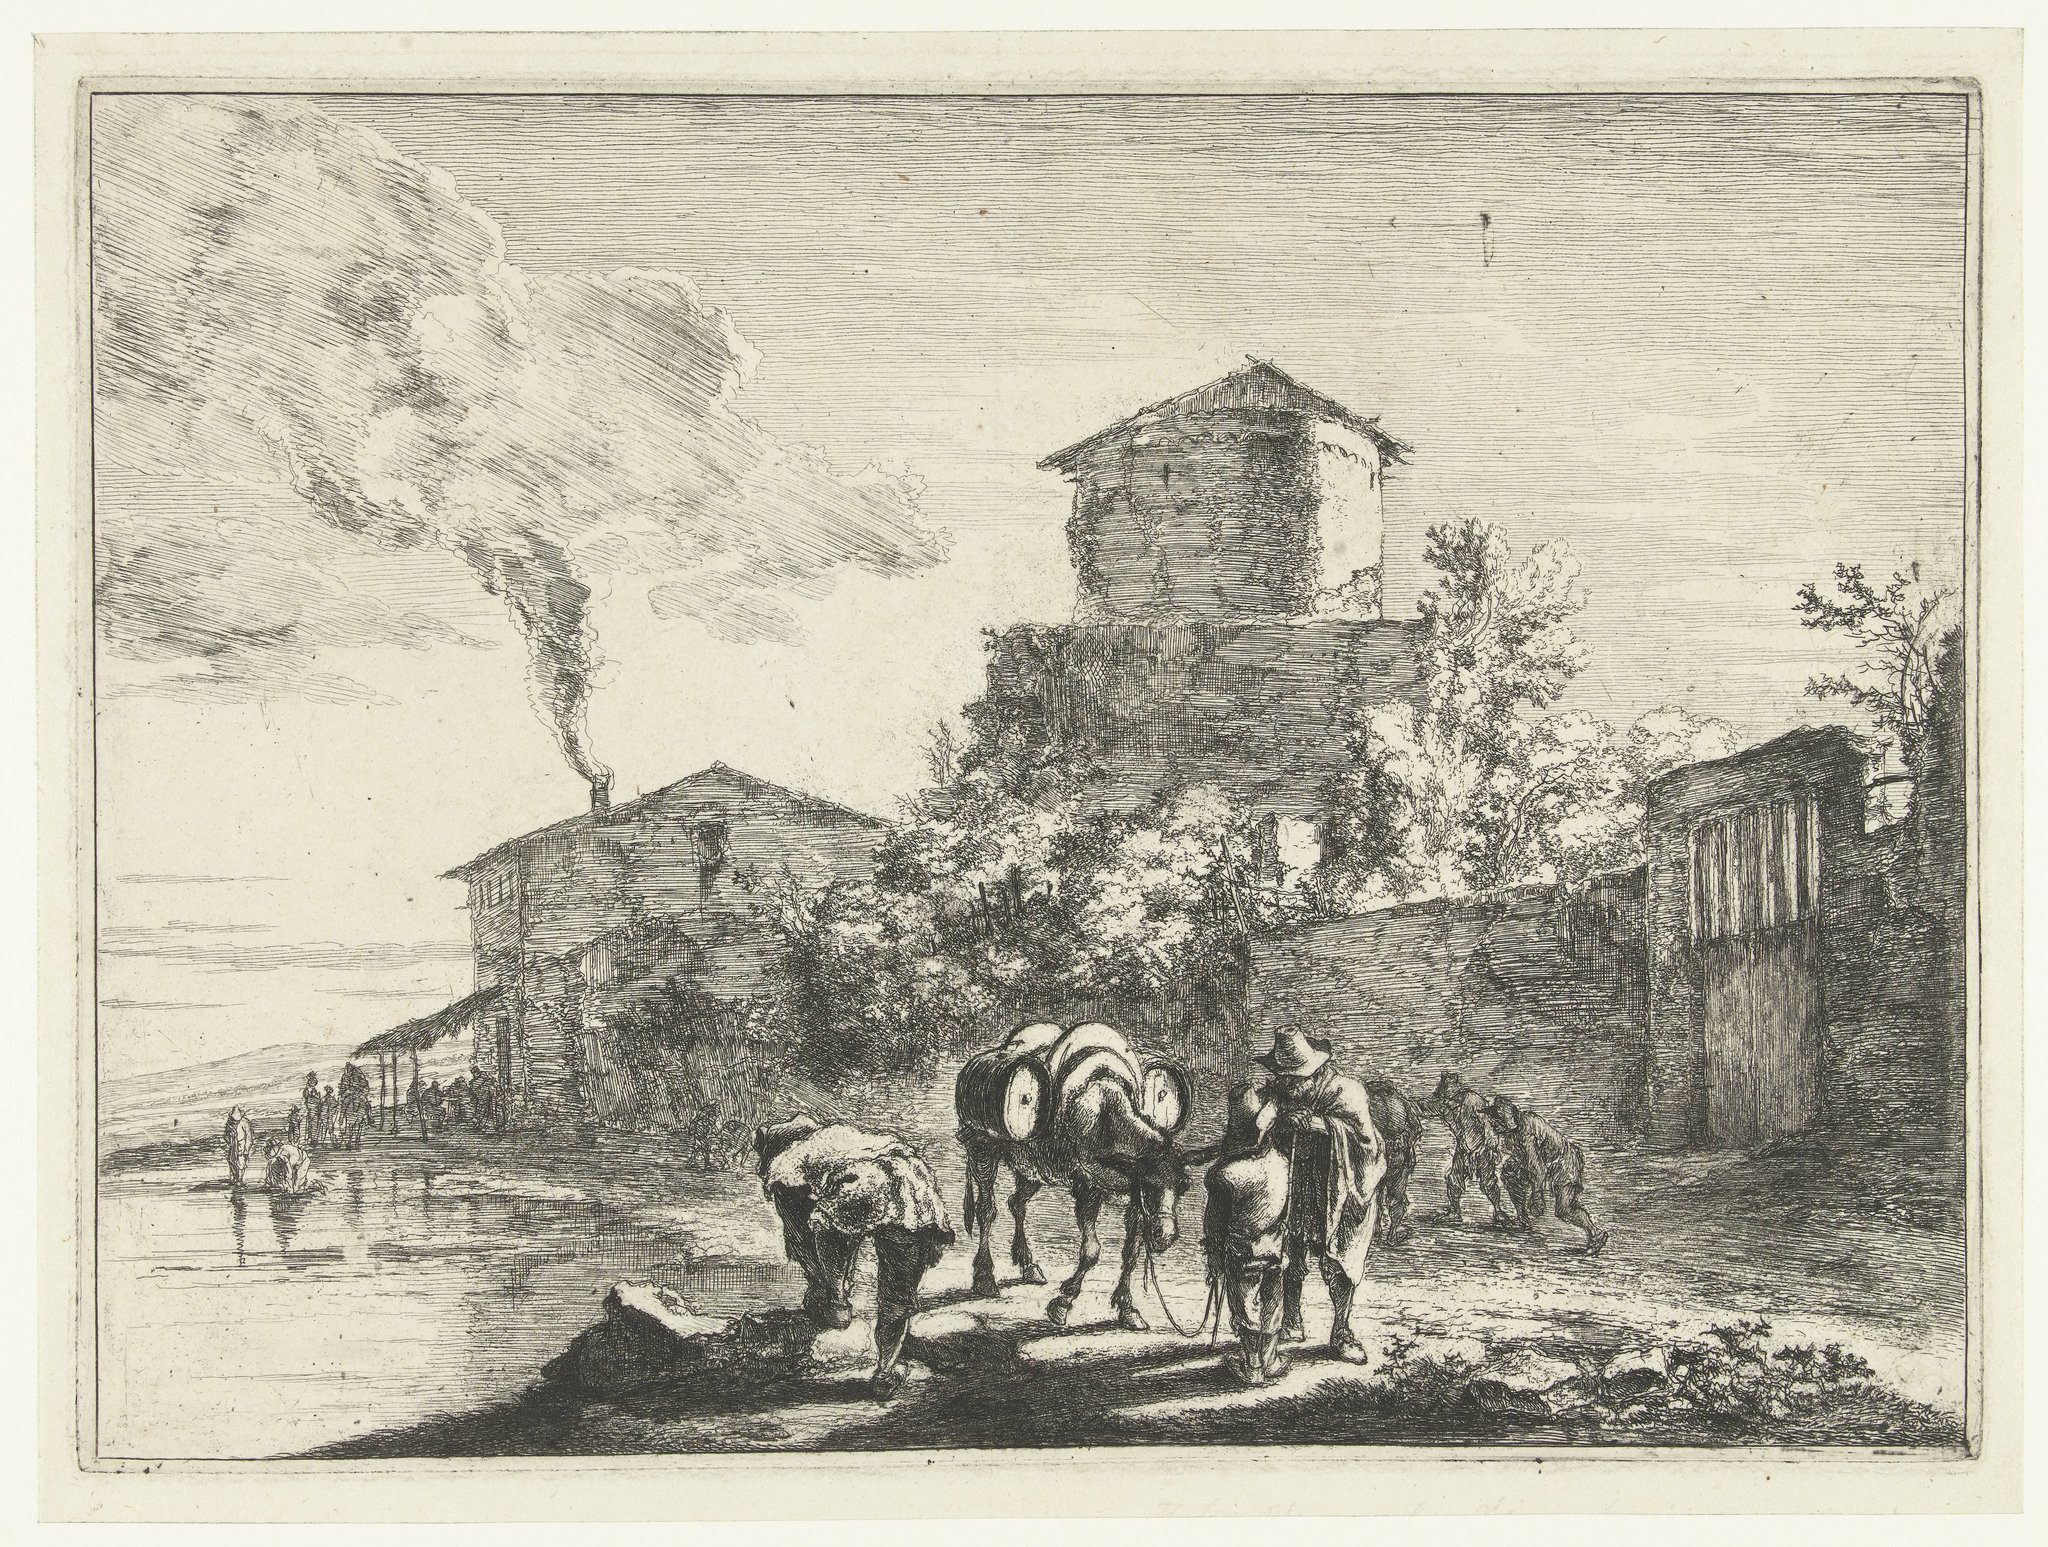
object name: print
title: Landschappen in de omgeving van Rome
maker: jan both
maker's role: draughtsman, painter, print maker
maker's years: 1618-1652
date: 1644-1652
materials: paper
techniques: etching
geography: utrecht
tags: mule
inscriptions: collector's mark: Lugt 240